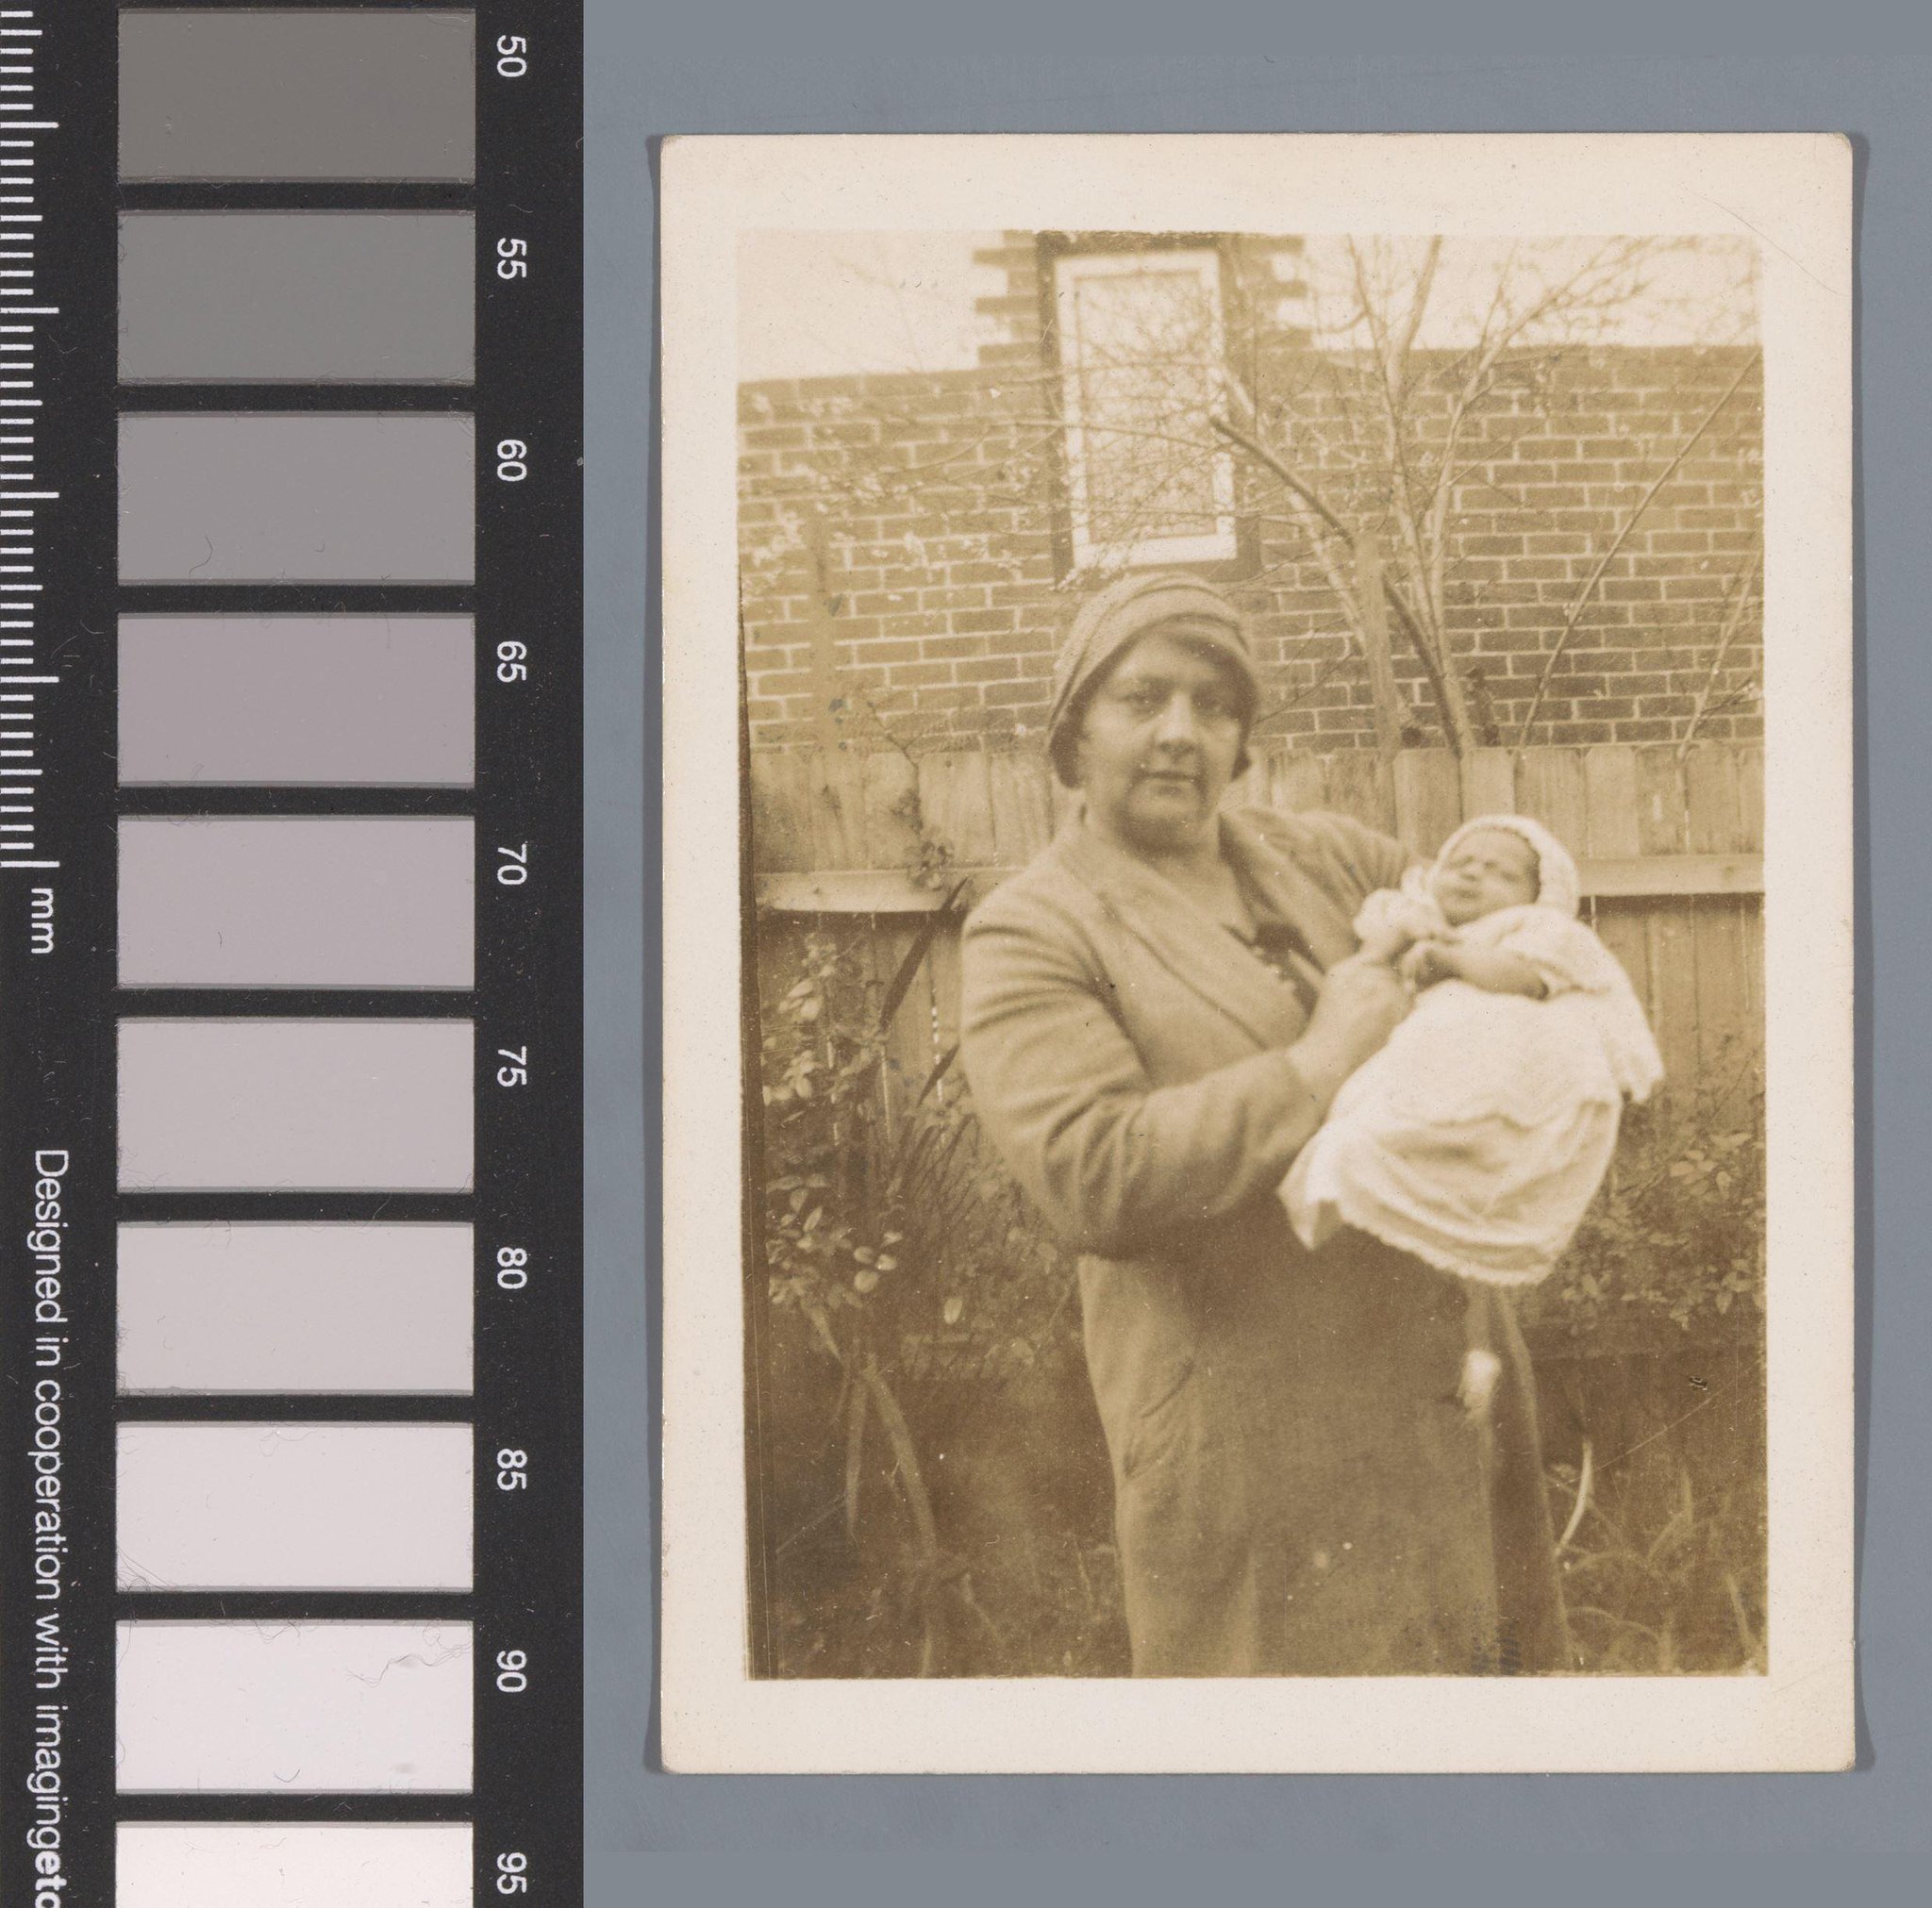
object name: photograph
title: Portret van een onbekende vrouw met een baby op de arm in een tuin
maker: Anonymous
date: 1924-1940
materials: photographic support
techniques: gelatin silver print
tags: mother and baby or young child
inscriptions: number: ‘A464’, inscription: ‘Zoon Janet’